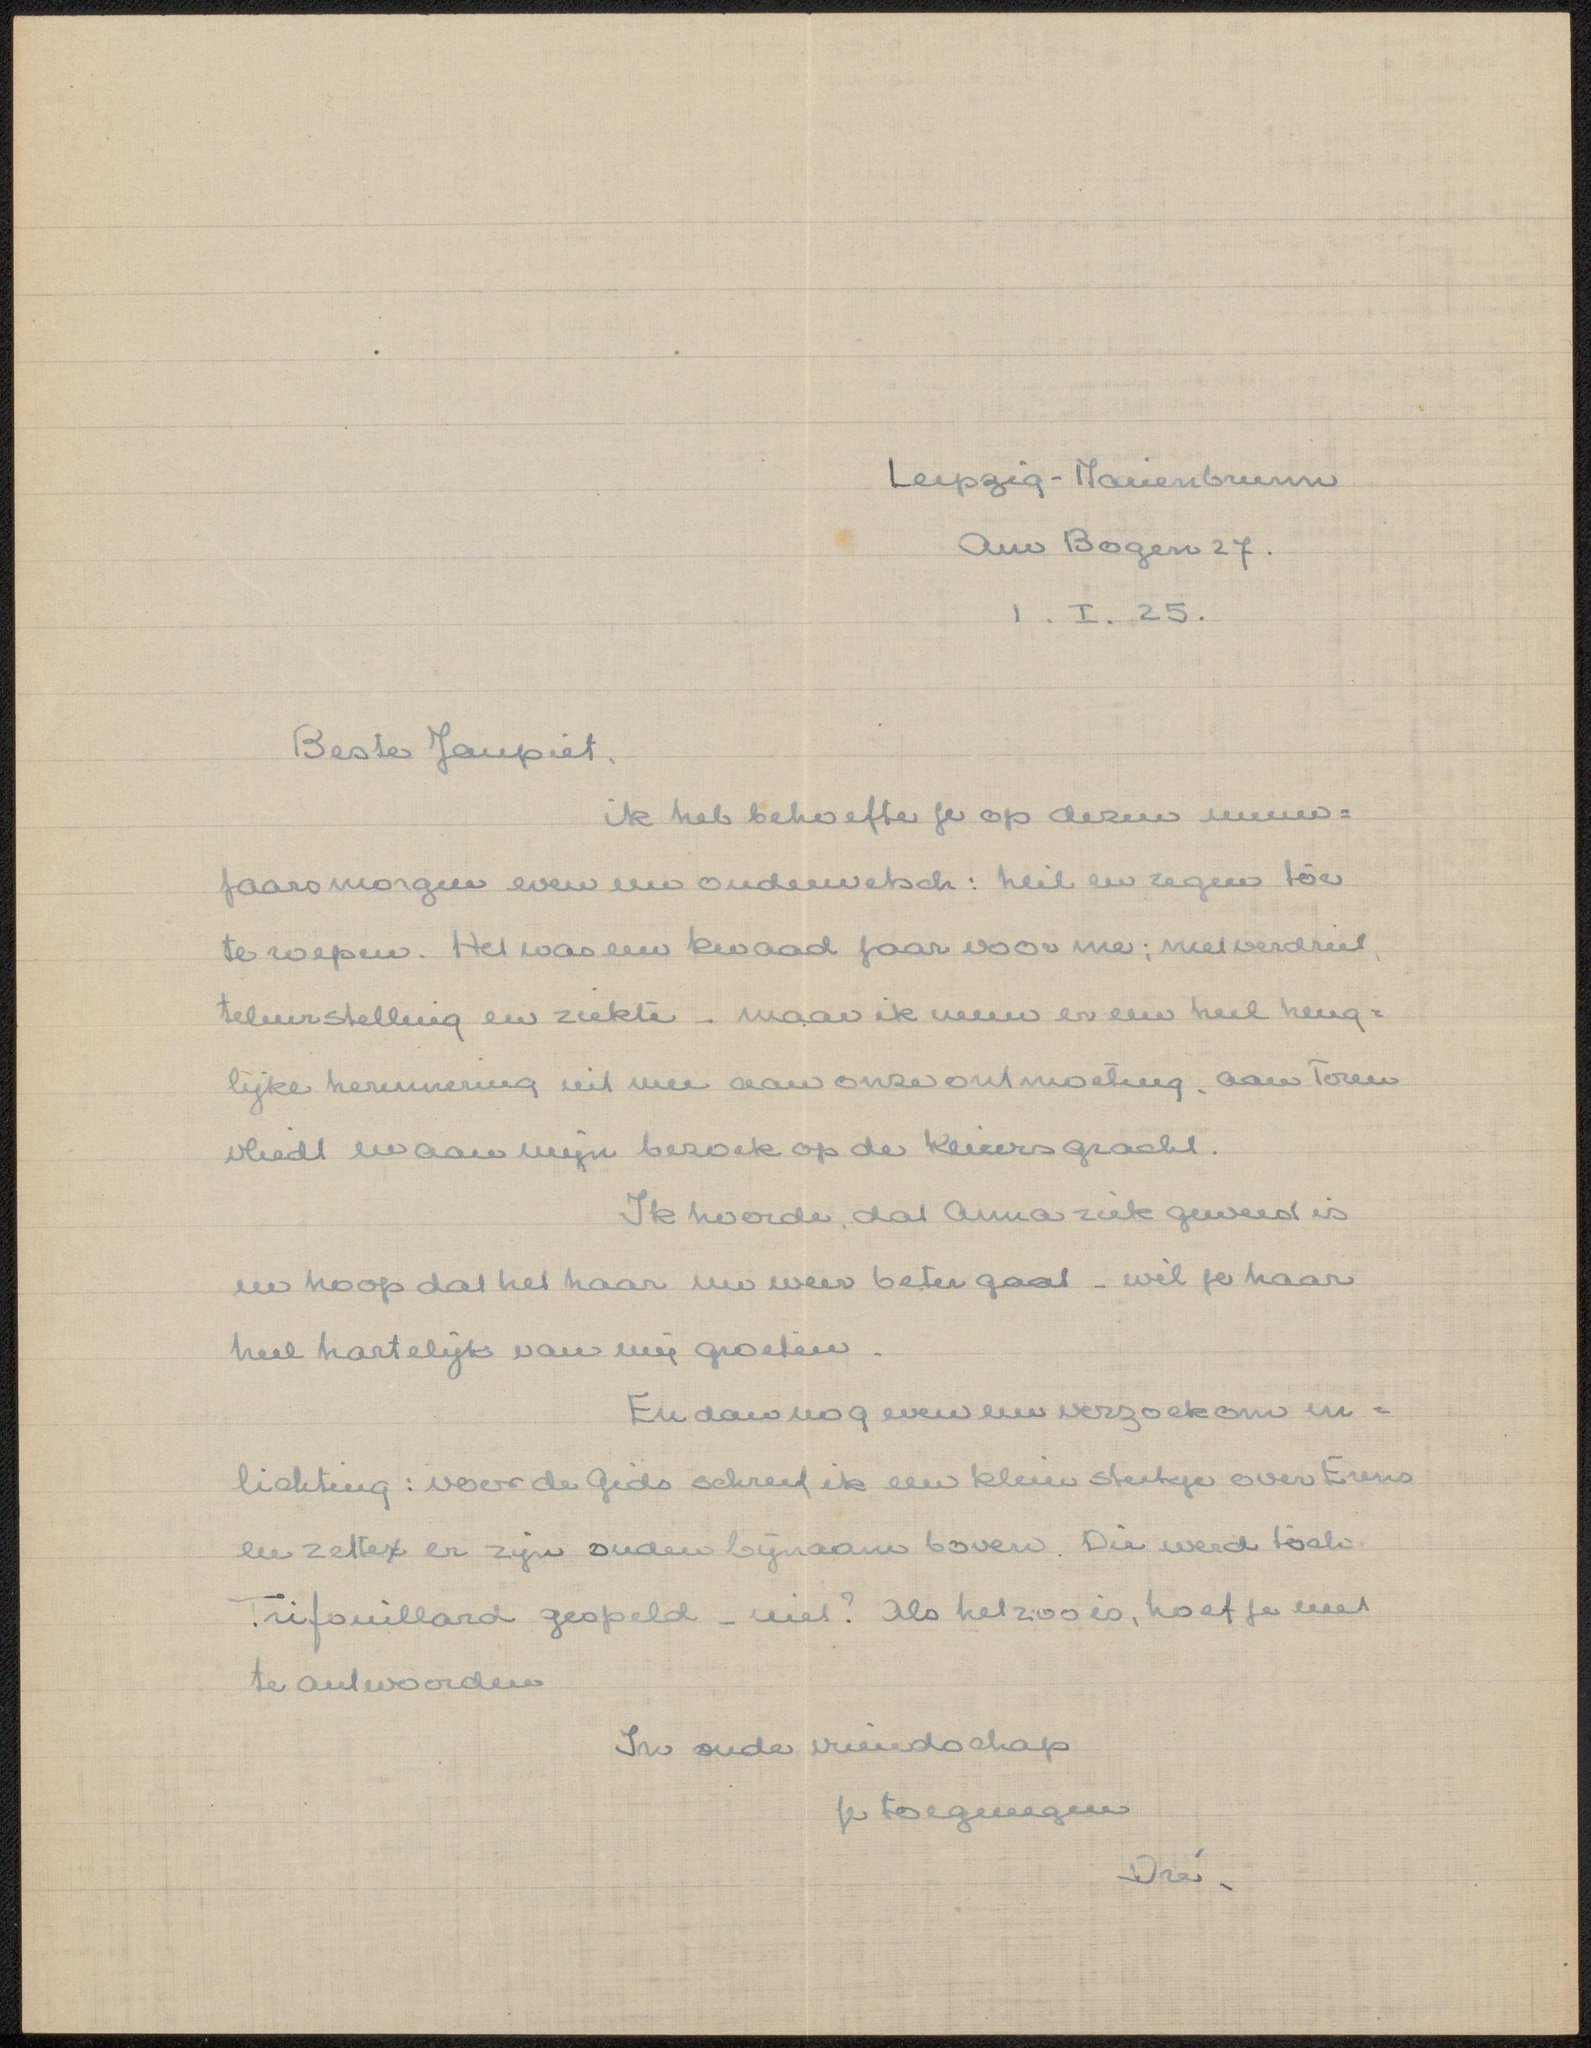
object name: letter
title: Brief aan Jan Veth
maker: andré jolles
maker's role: journalist, kunsthistoricus, letterkundige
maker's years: 1874-1946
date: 1925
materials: ink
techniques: pen, writing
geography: leipzig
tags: amsterdam, painter, draughtsman, designer, jan veth, frans erens, diseases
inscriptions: collector's mark: ‘RPK’